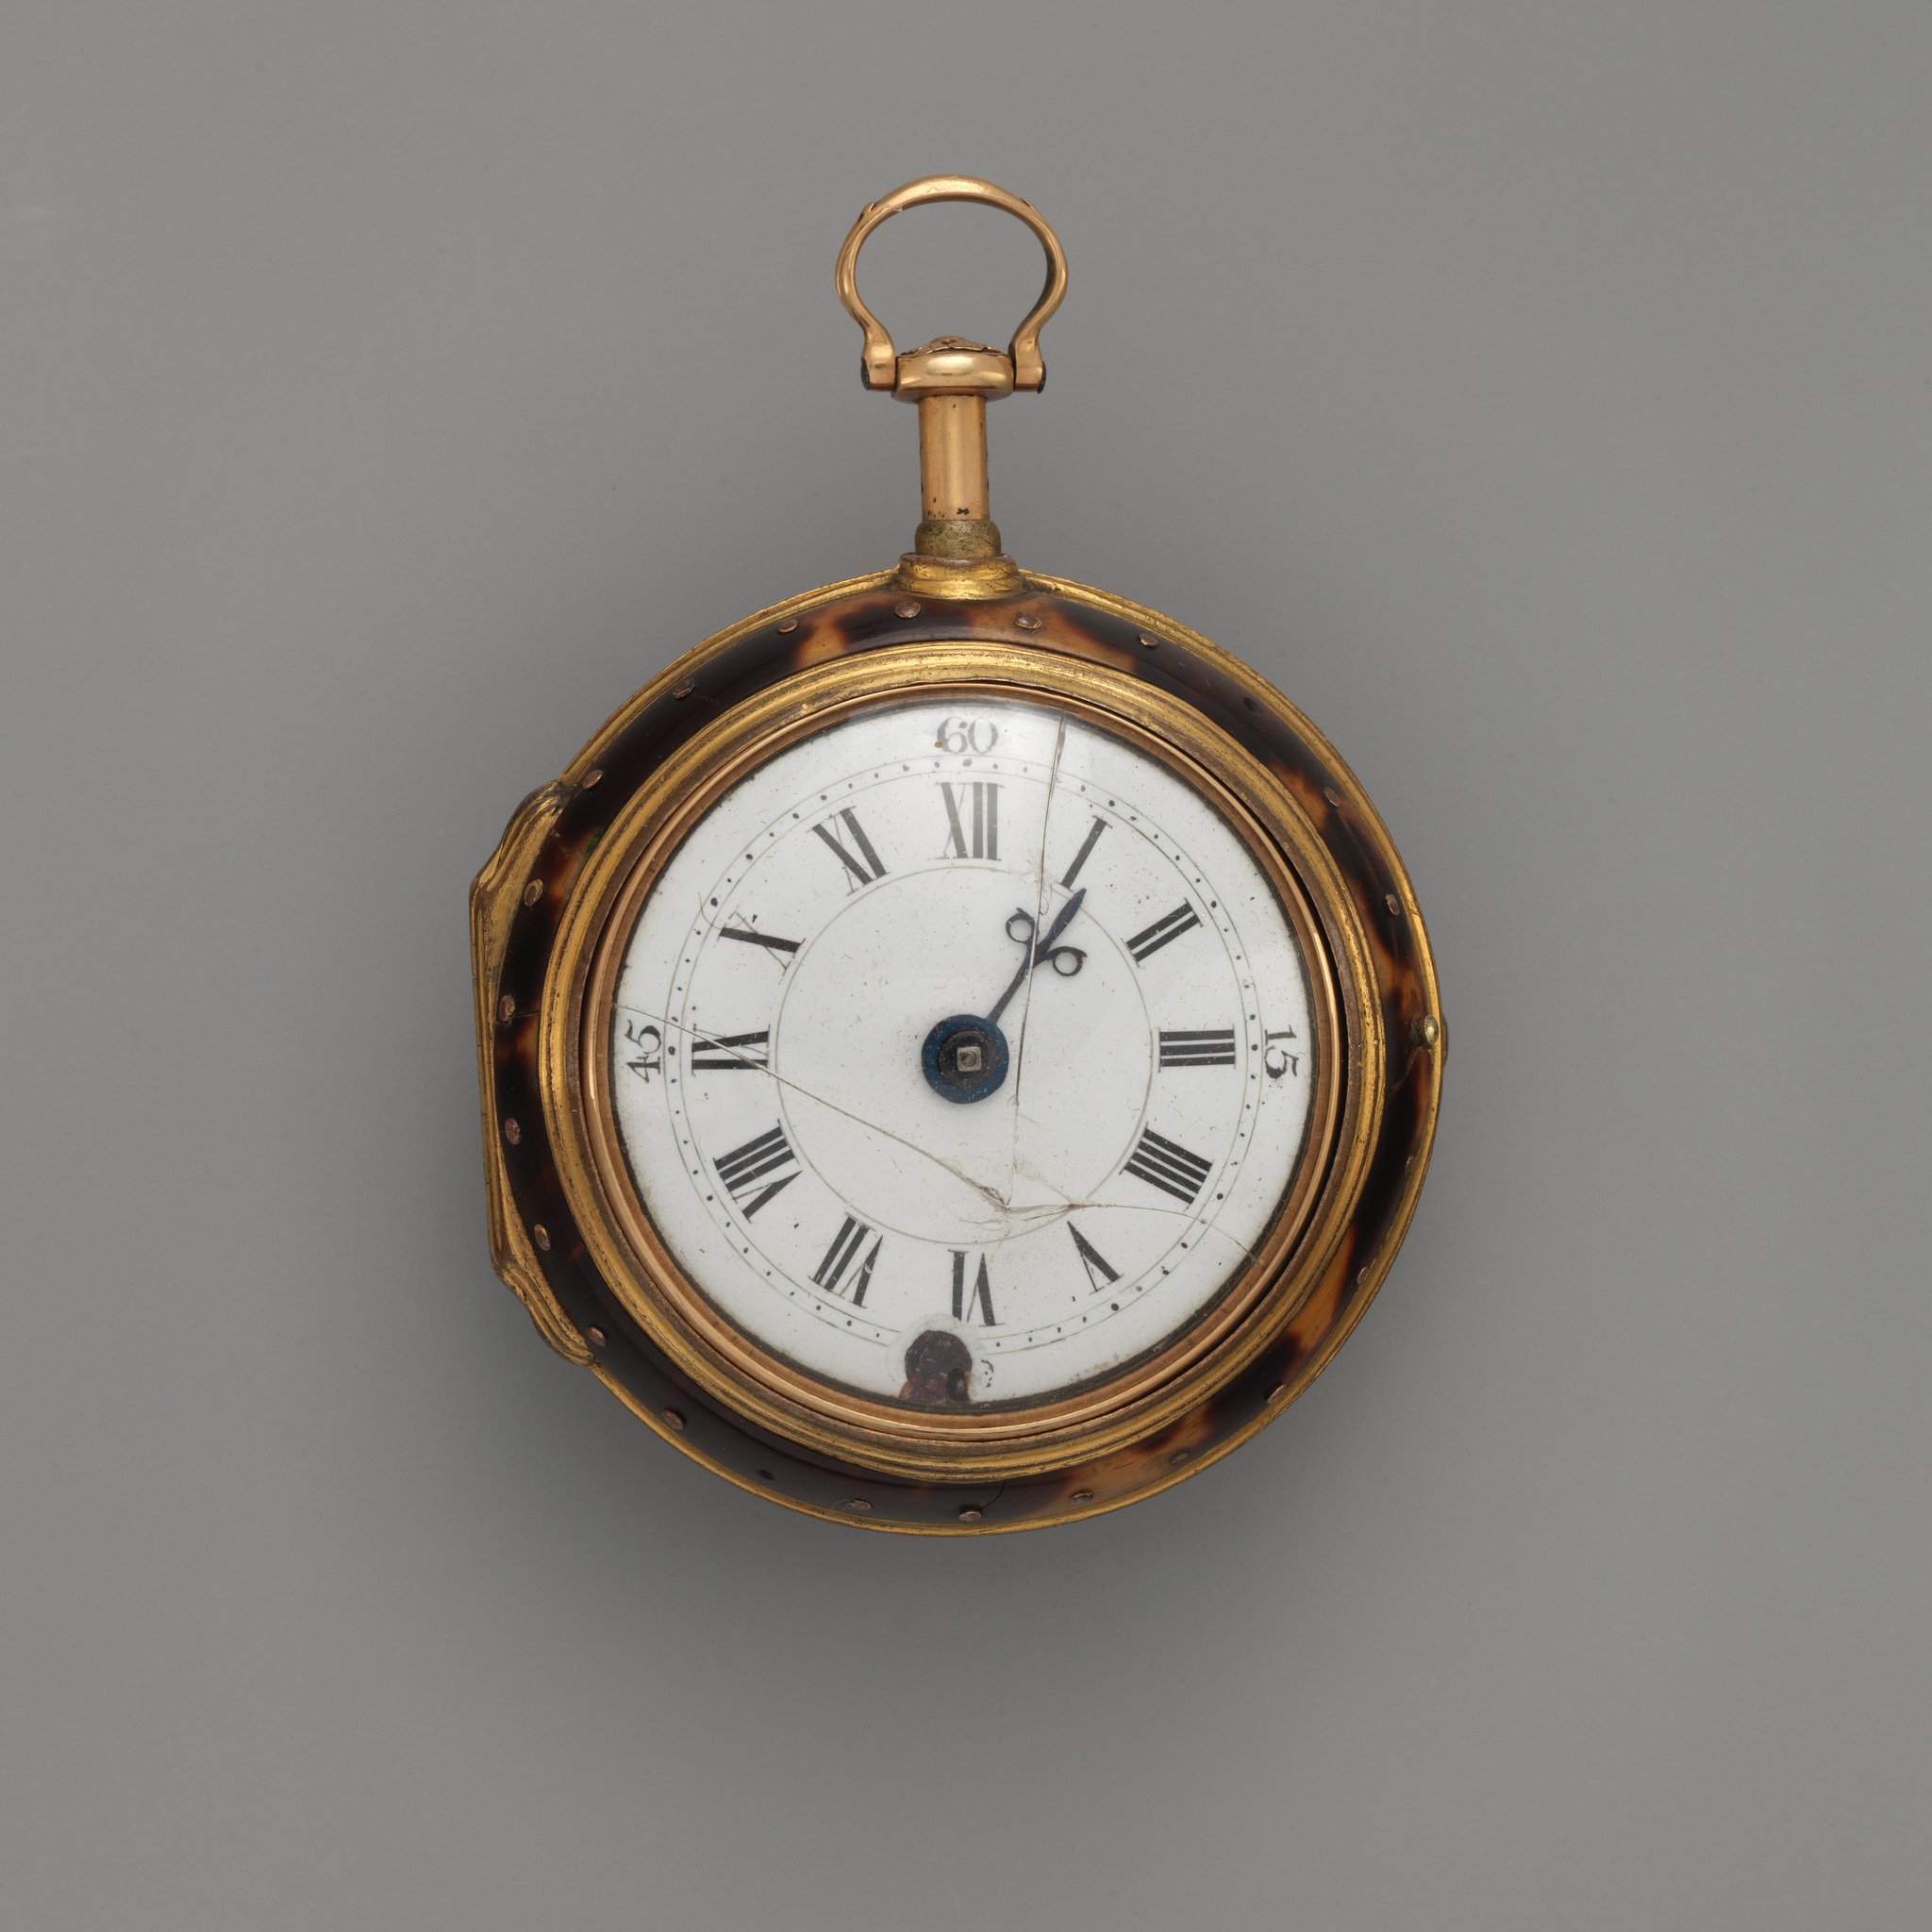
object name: watch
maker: charles coulon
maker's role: maker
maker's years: 1765-1770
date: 1770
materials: enamel, gold, shell